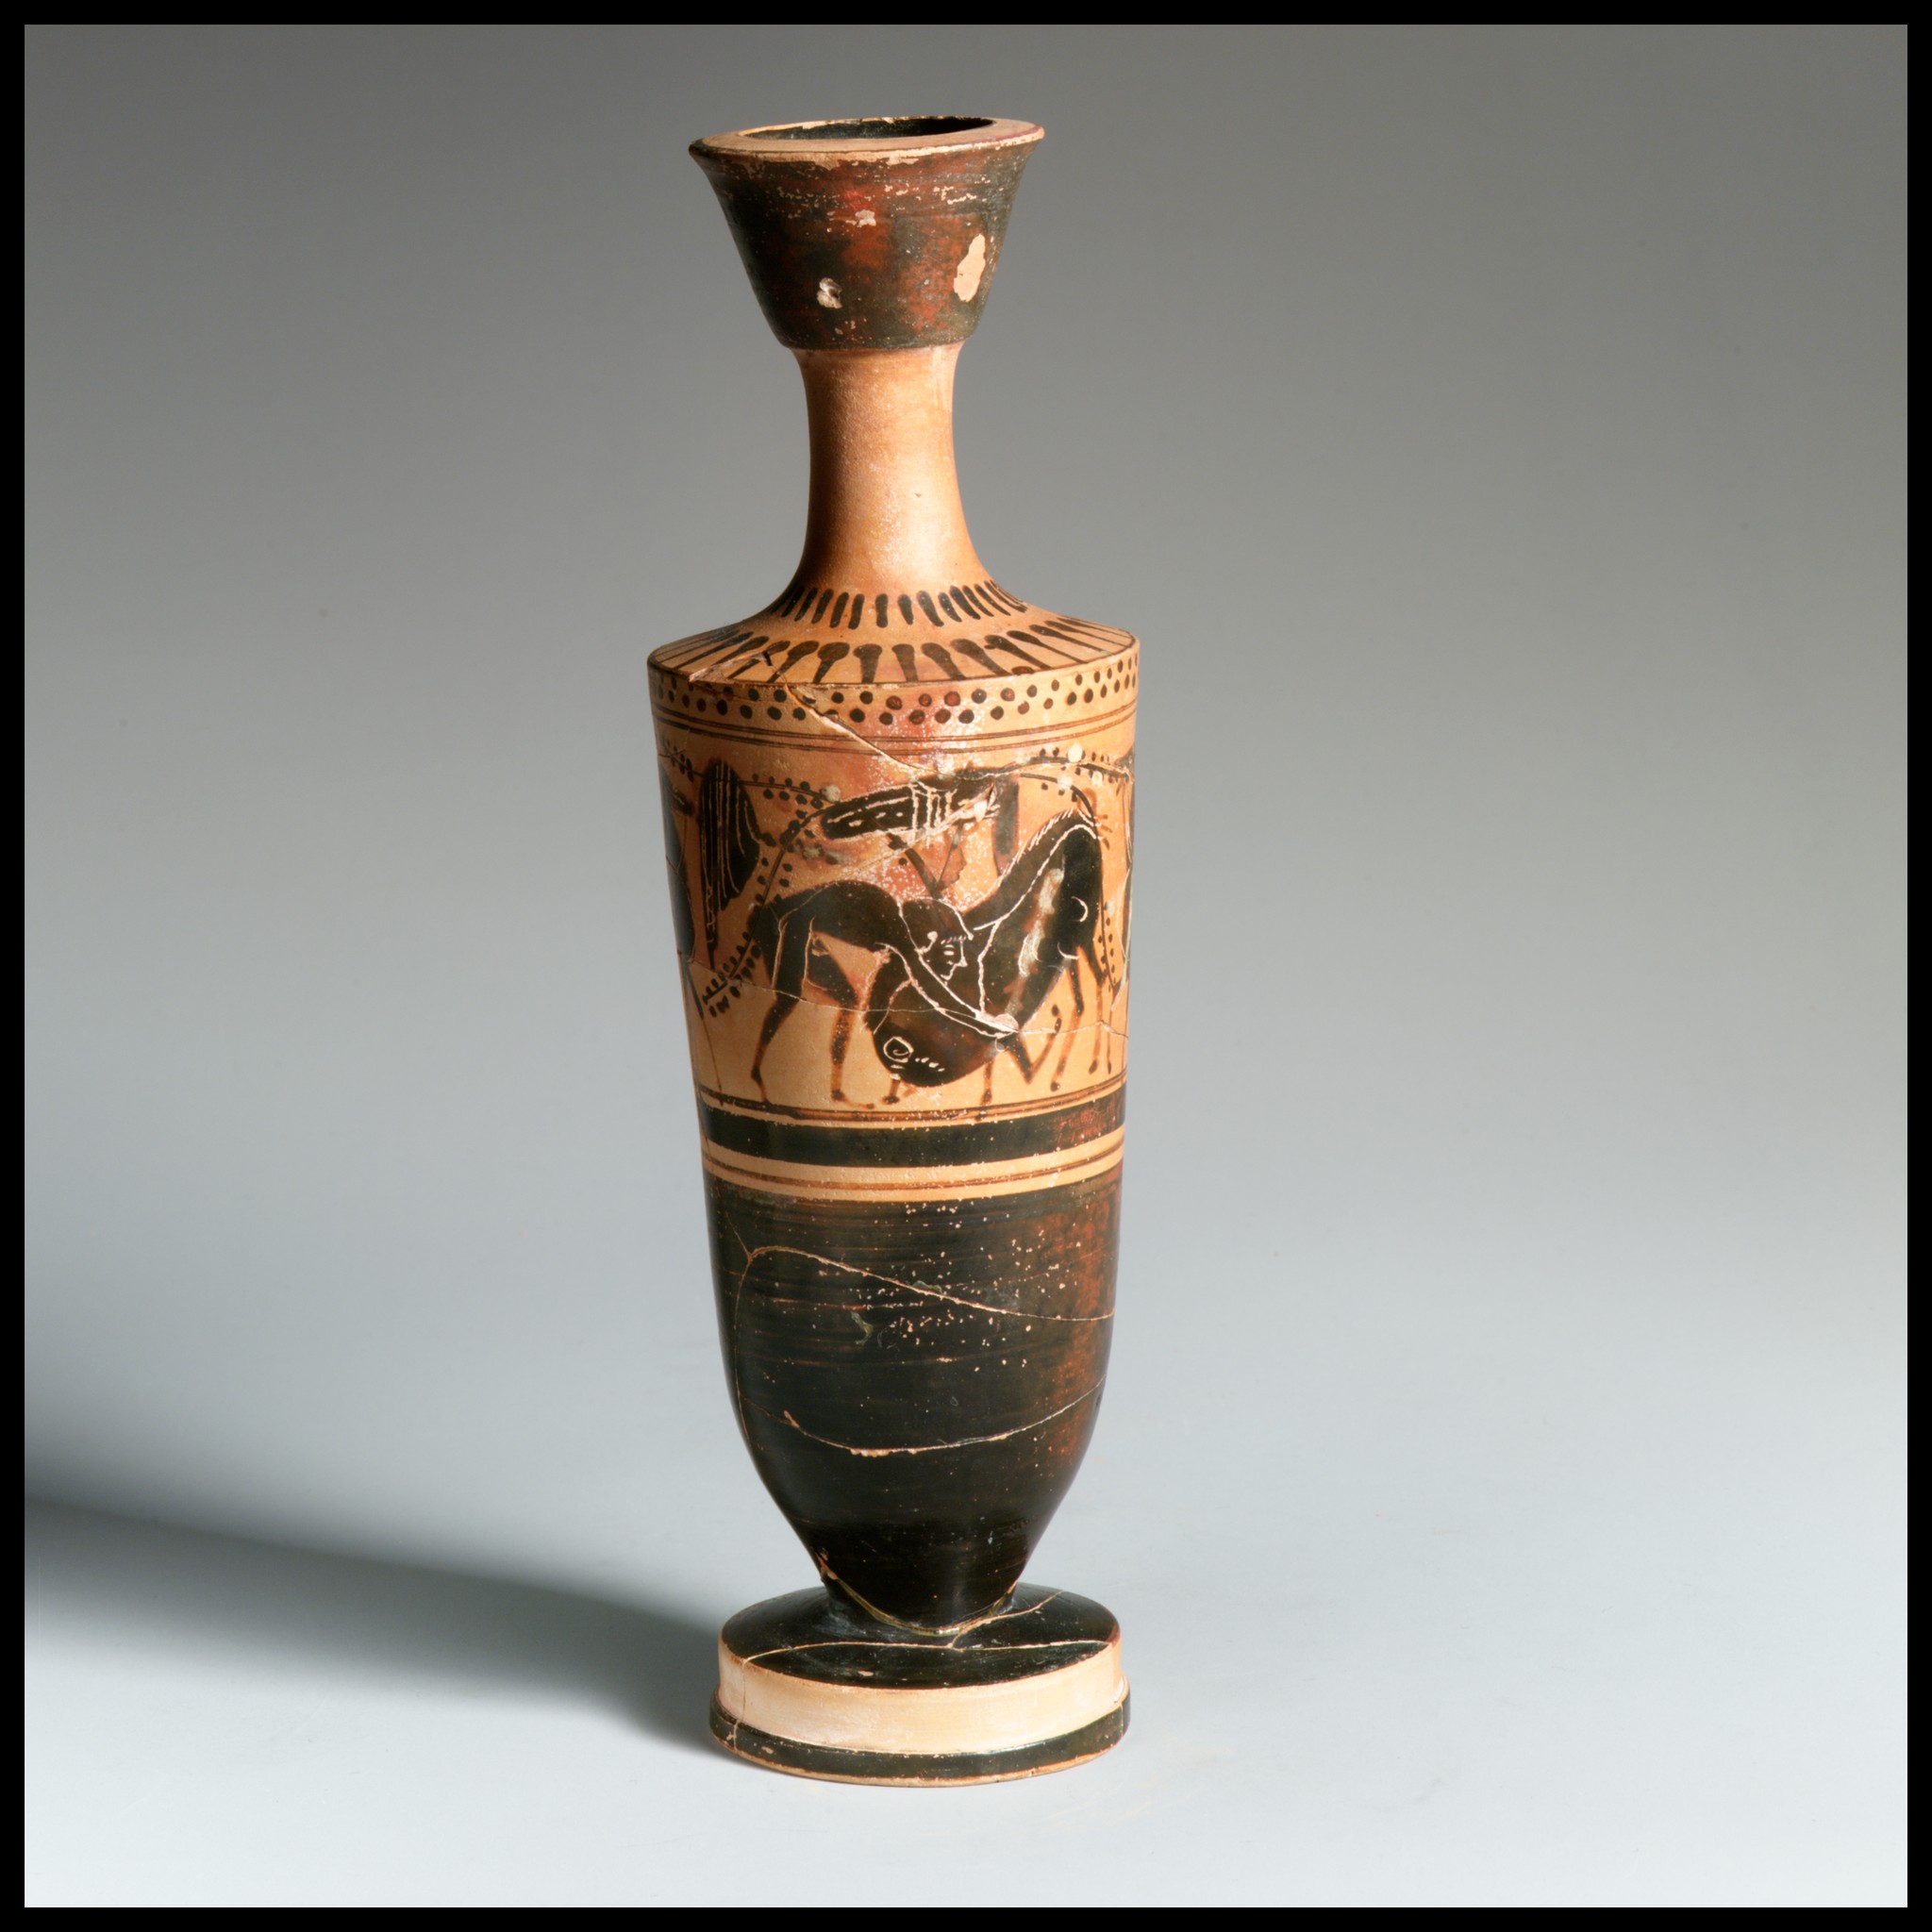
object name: lekythos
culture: greek, attic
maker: haimon painter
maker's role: artist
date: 480 BCE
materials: terracotta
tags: amazons,boars,herakles